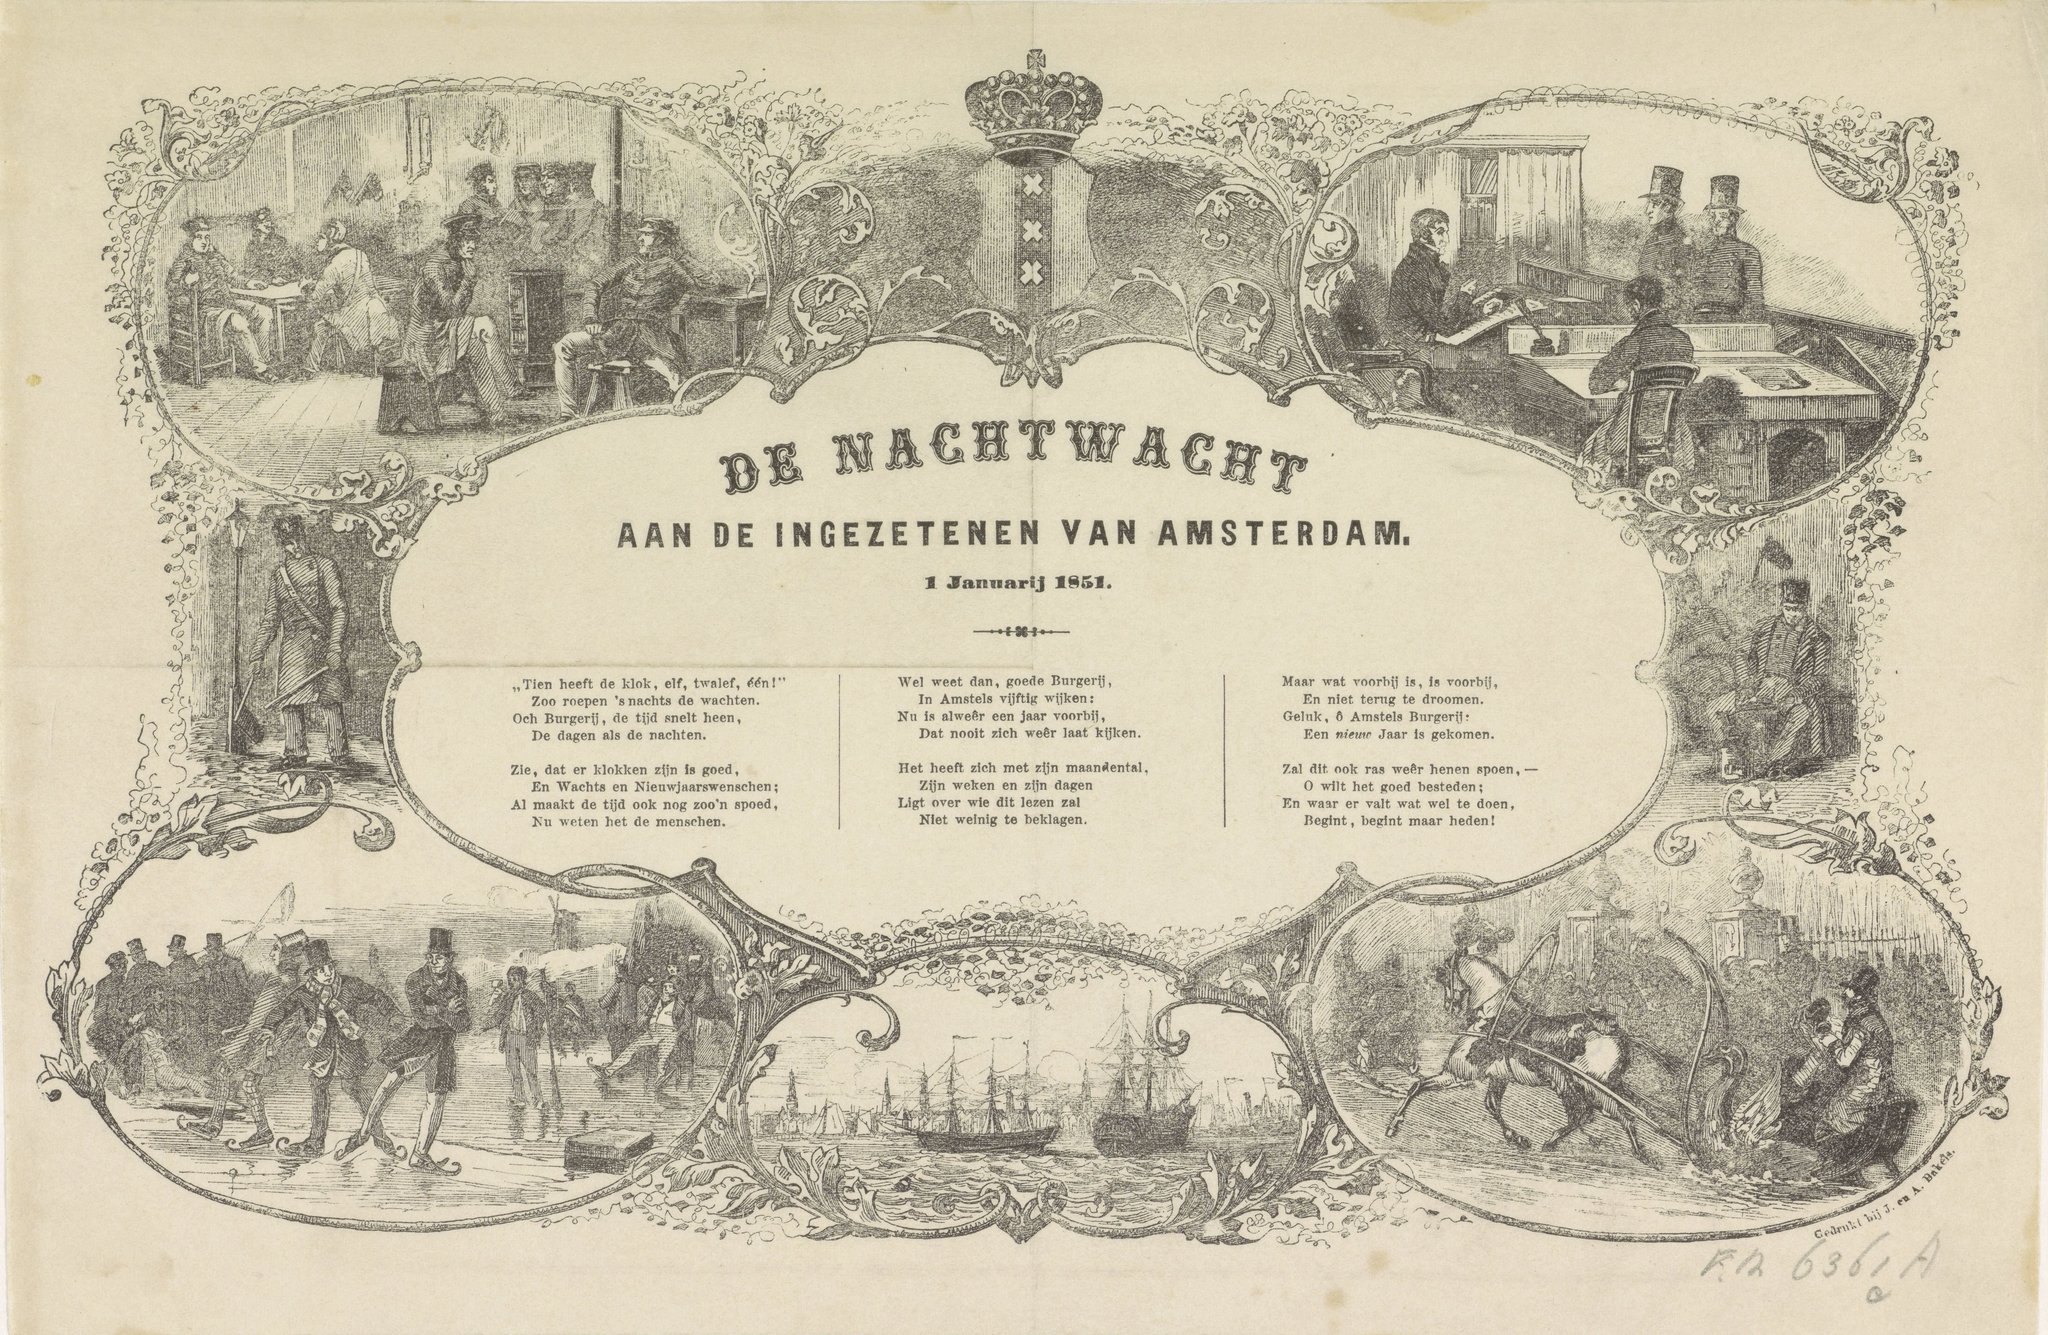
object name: print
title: Nieuwjaarswens van de Amsterdamse nachtwacht voor het jaar 1851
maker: Anonymous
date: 1850-1851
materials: paper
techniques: letterpress printing, engraving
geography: amsterdam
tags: night patrol, skates (winter sports), sledge, sleigh (winter sports), police, amsterdam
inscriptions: collector's mark: Lugt 2228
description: Nieuwjaarswens van de Amsterdamse nachtwacht (ratelwacht) voor het jaar 1851. Centraal een gedicht in drie kolommen omringd door zeven kleine scènes van wachten in het nachtwachtshuisje, politiebureau, vermaak op het ijs en schepen op het IJ.